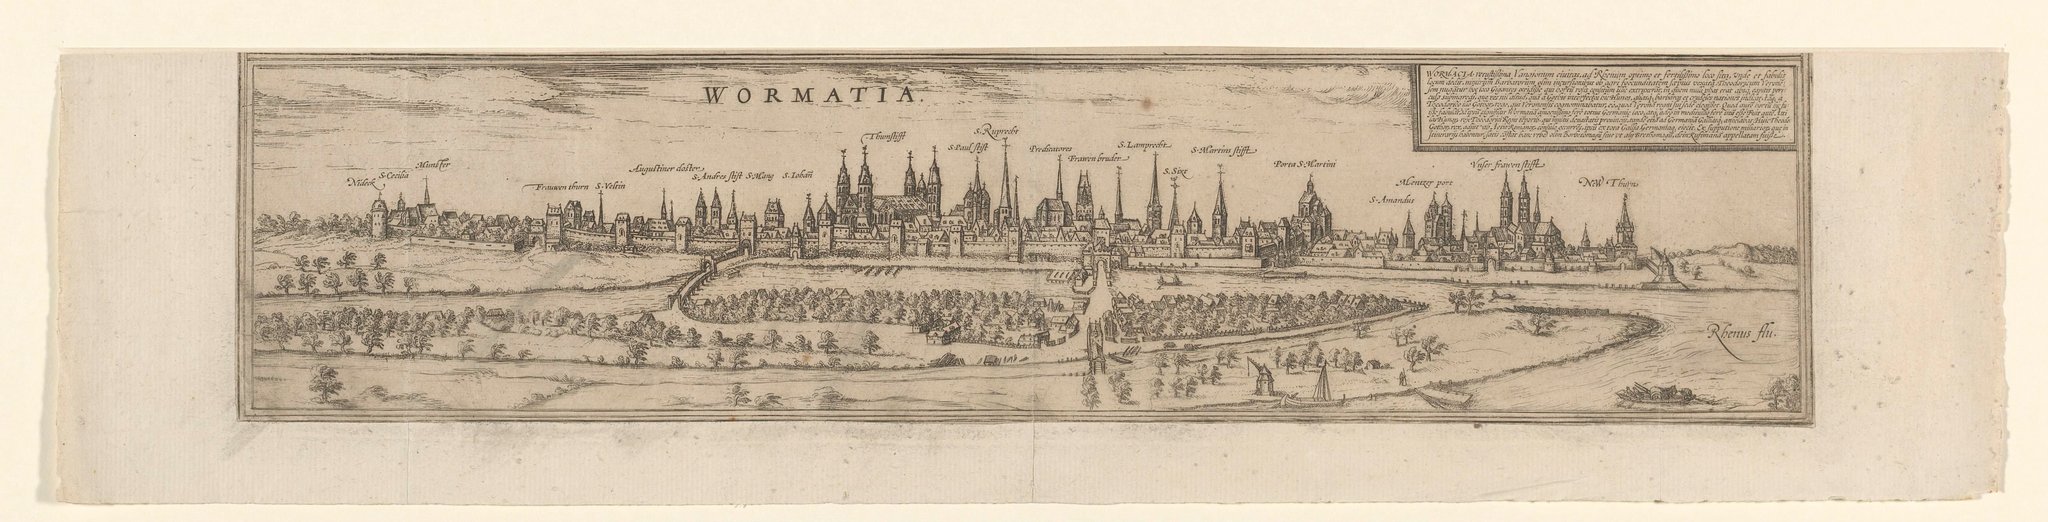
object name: print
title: Wormatia / Wormacia vetustissima Vangionum vivitas, ad Rhenium (...)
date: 1574-1657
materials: paper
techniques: engraving, etching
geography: amsterdam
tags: prospect of city, town panorama, silhouette of city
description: Deze prent is afgesneden van een blad met twee andere stadsgezichten, van Heidelberg en Speyer (RP-P-2018-2044). De prent is vanaf 1574 voorgekomen in Braun en Hogenbergs Bescheibung und Contrafacur der vornembster Stät der Welt en vanaf 1575 in hun Civitates Orbis Terrarum. Daarna heeft Johannes Janssonius de prent uitgegeven in zijn stedenatlas van 1657.